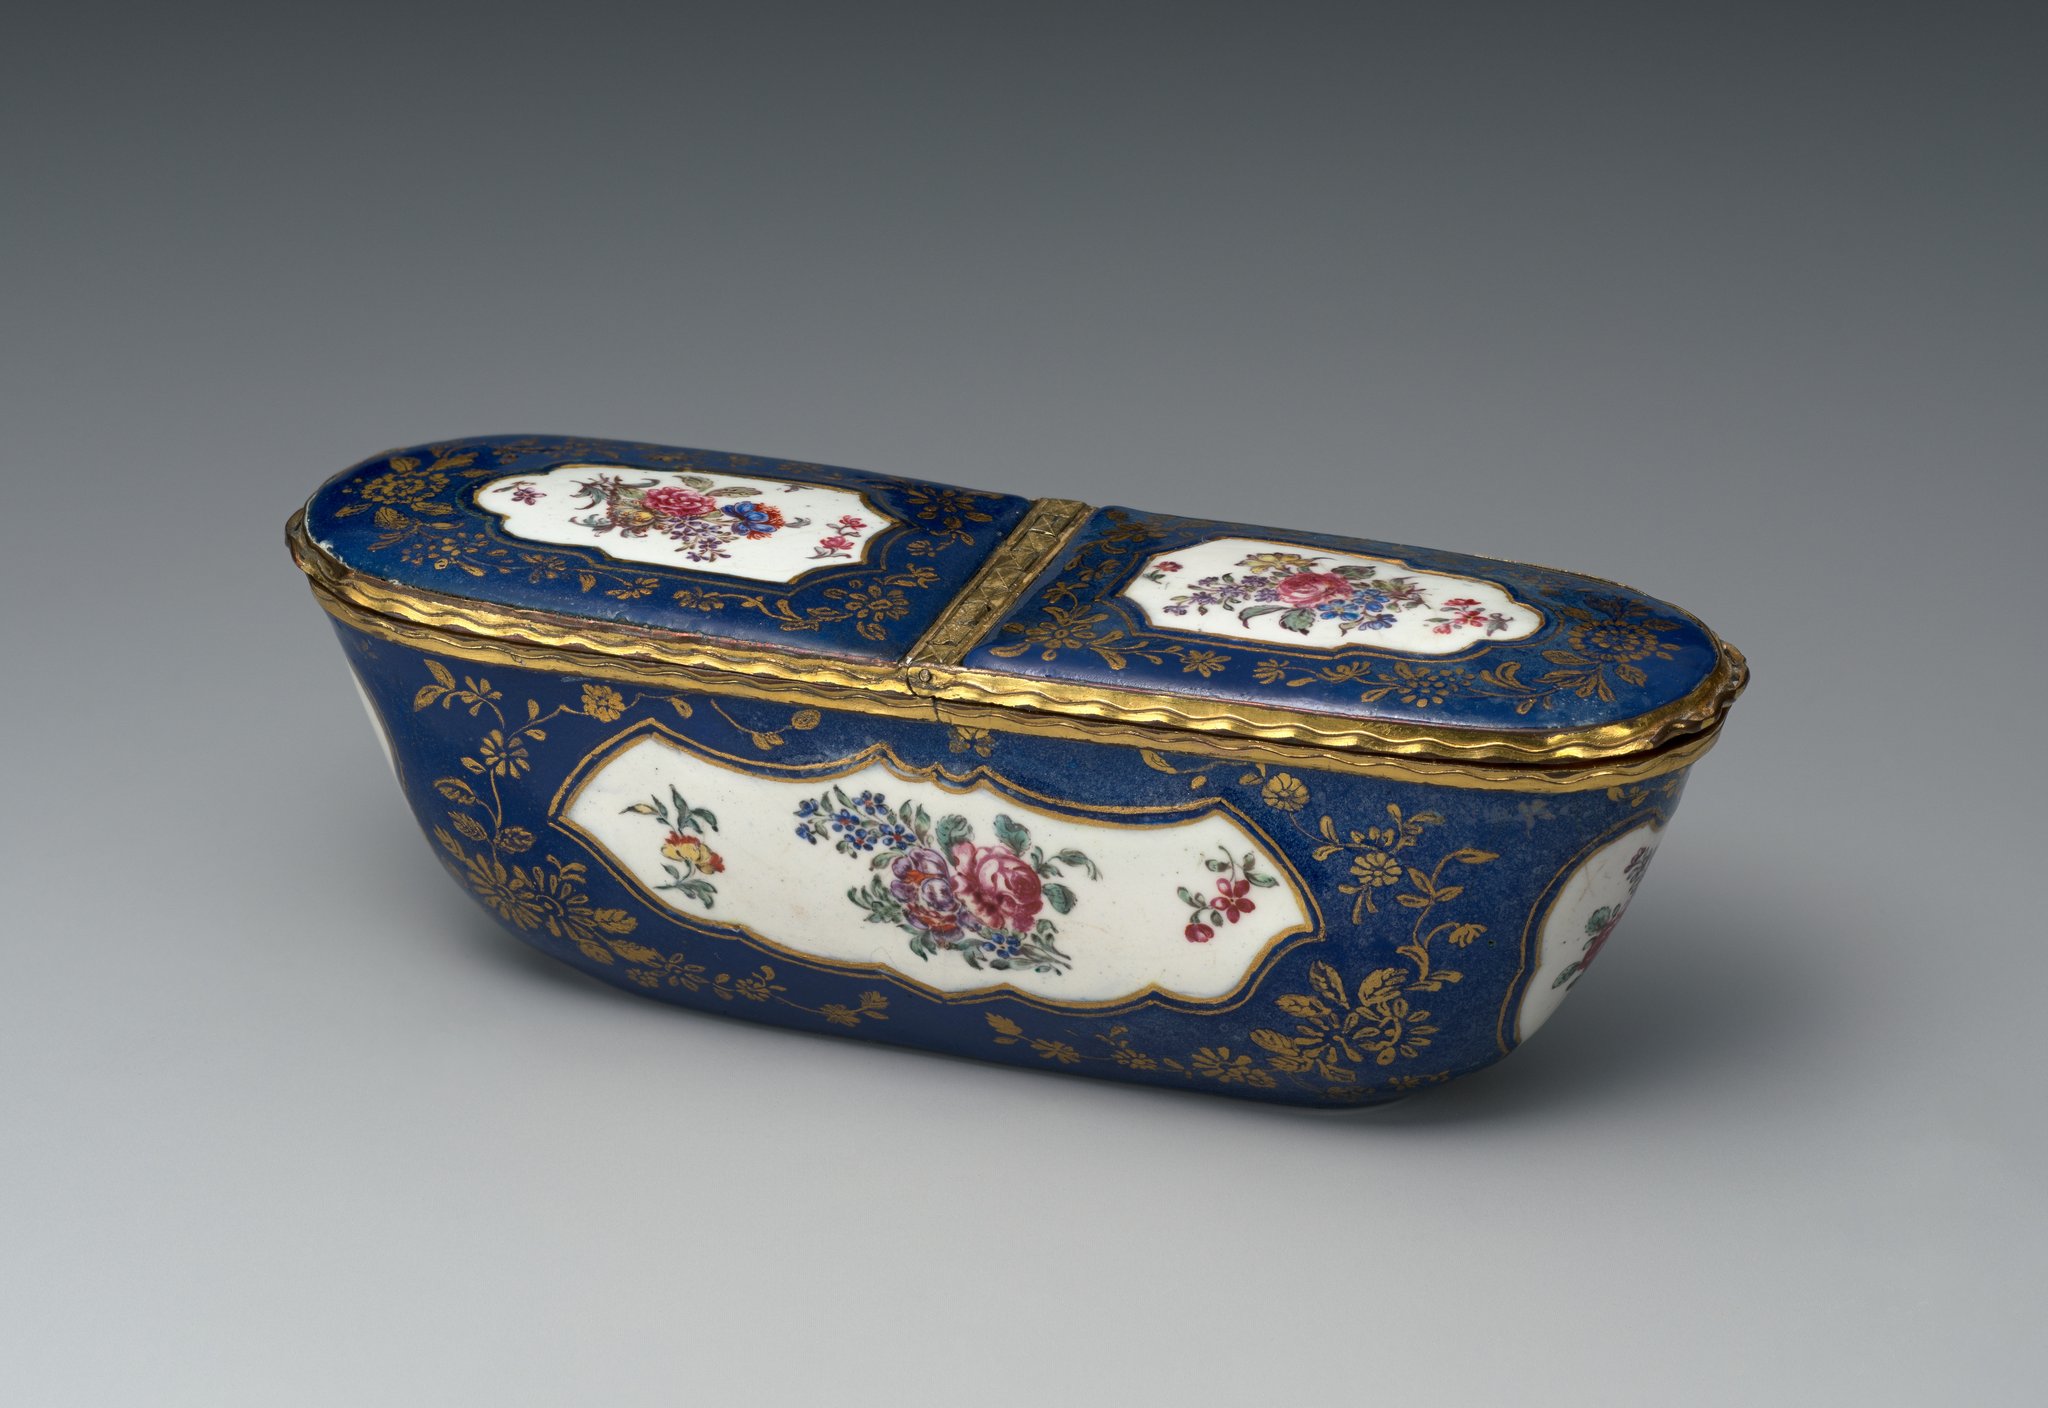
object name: double lidded snuffbox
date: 1750-1759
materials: copper, enamel